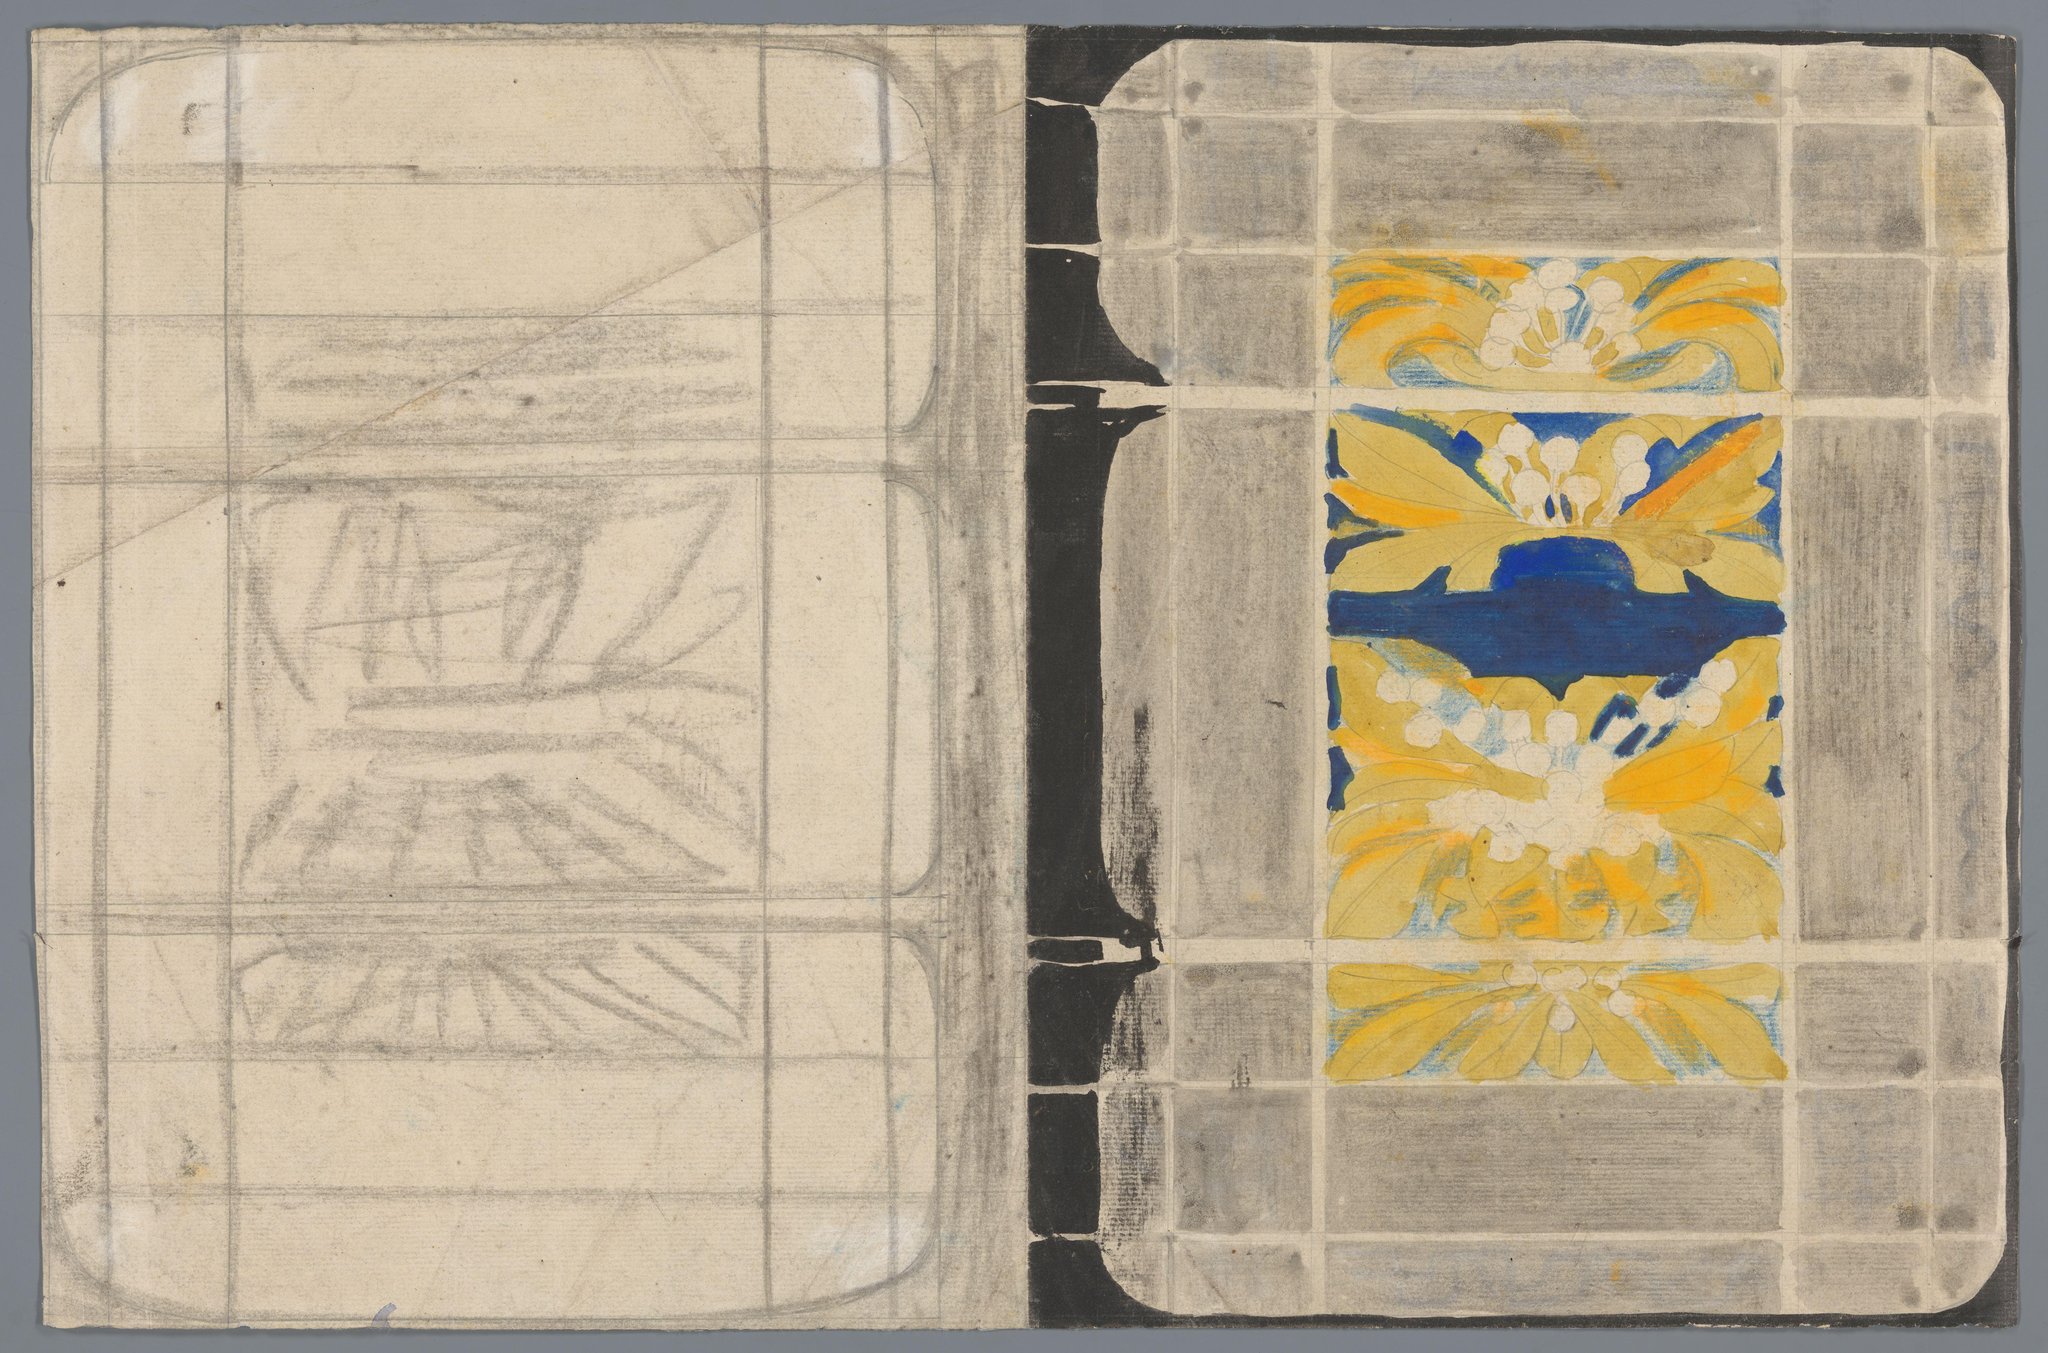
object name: design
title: Ontwerp voor een boekband met bloemmotief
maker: carel adolph lion cachet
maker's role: draughtsman, print maker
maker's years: 1864-1945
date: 1874-1945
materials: charcoal, paper, pencil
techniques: brush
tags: book-cover, binding, flowers ~ ornament